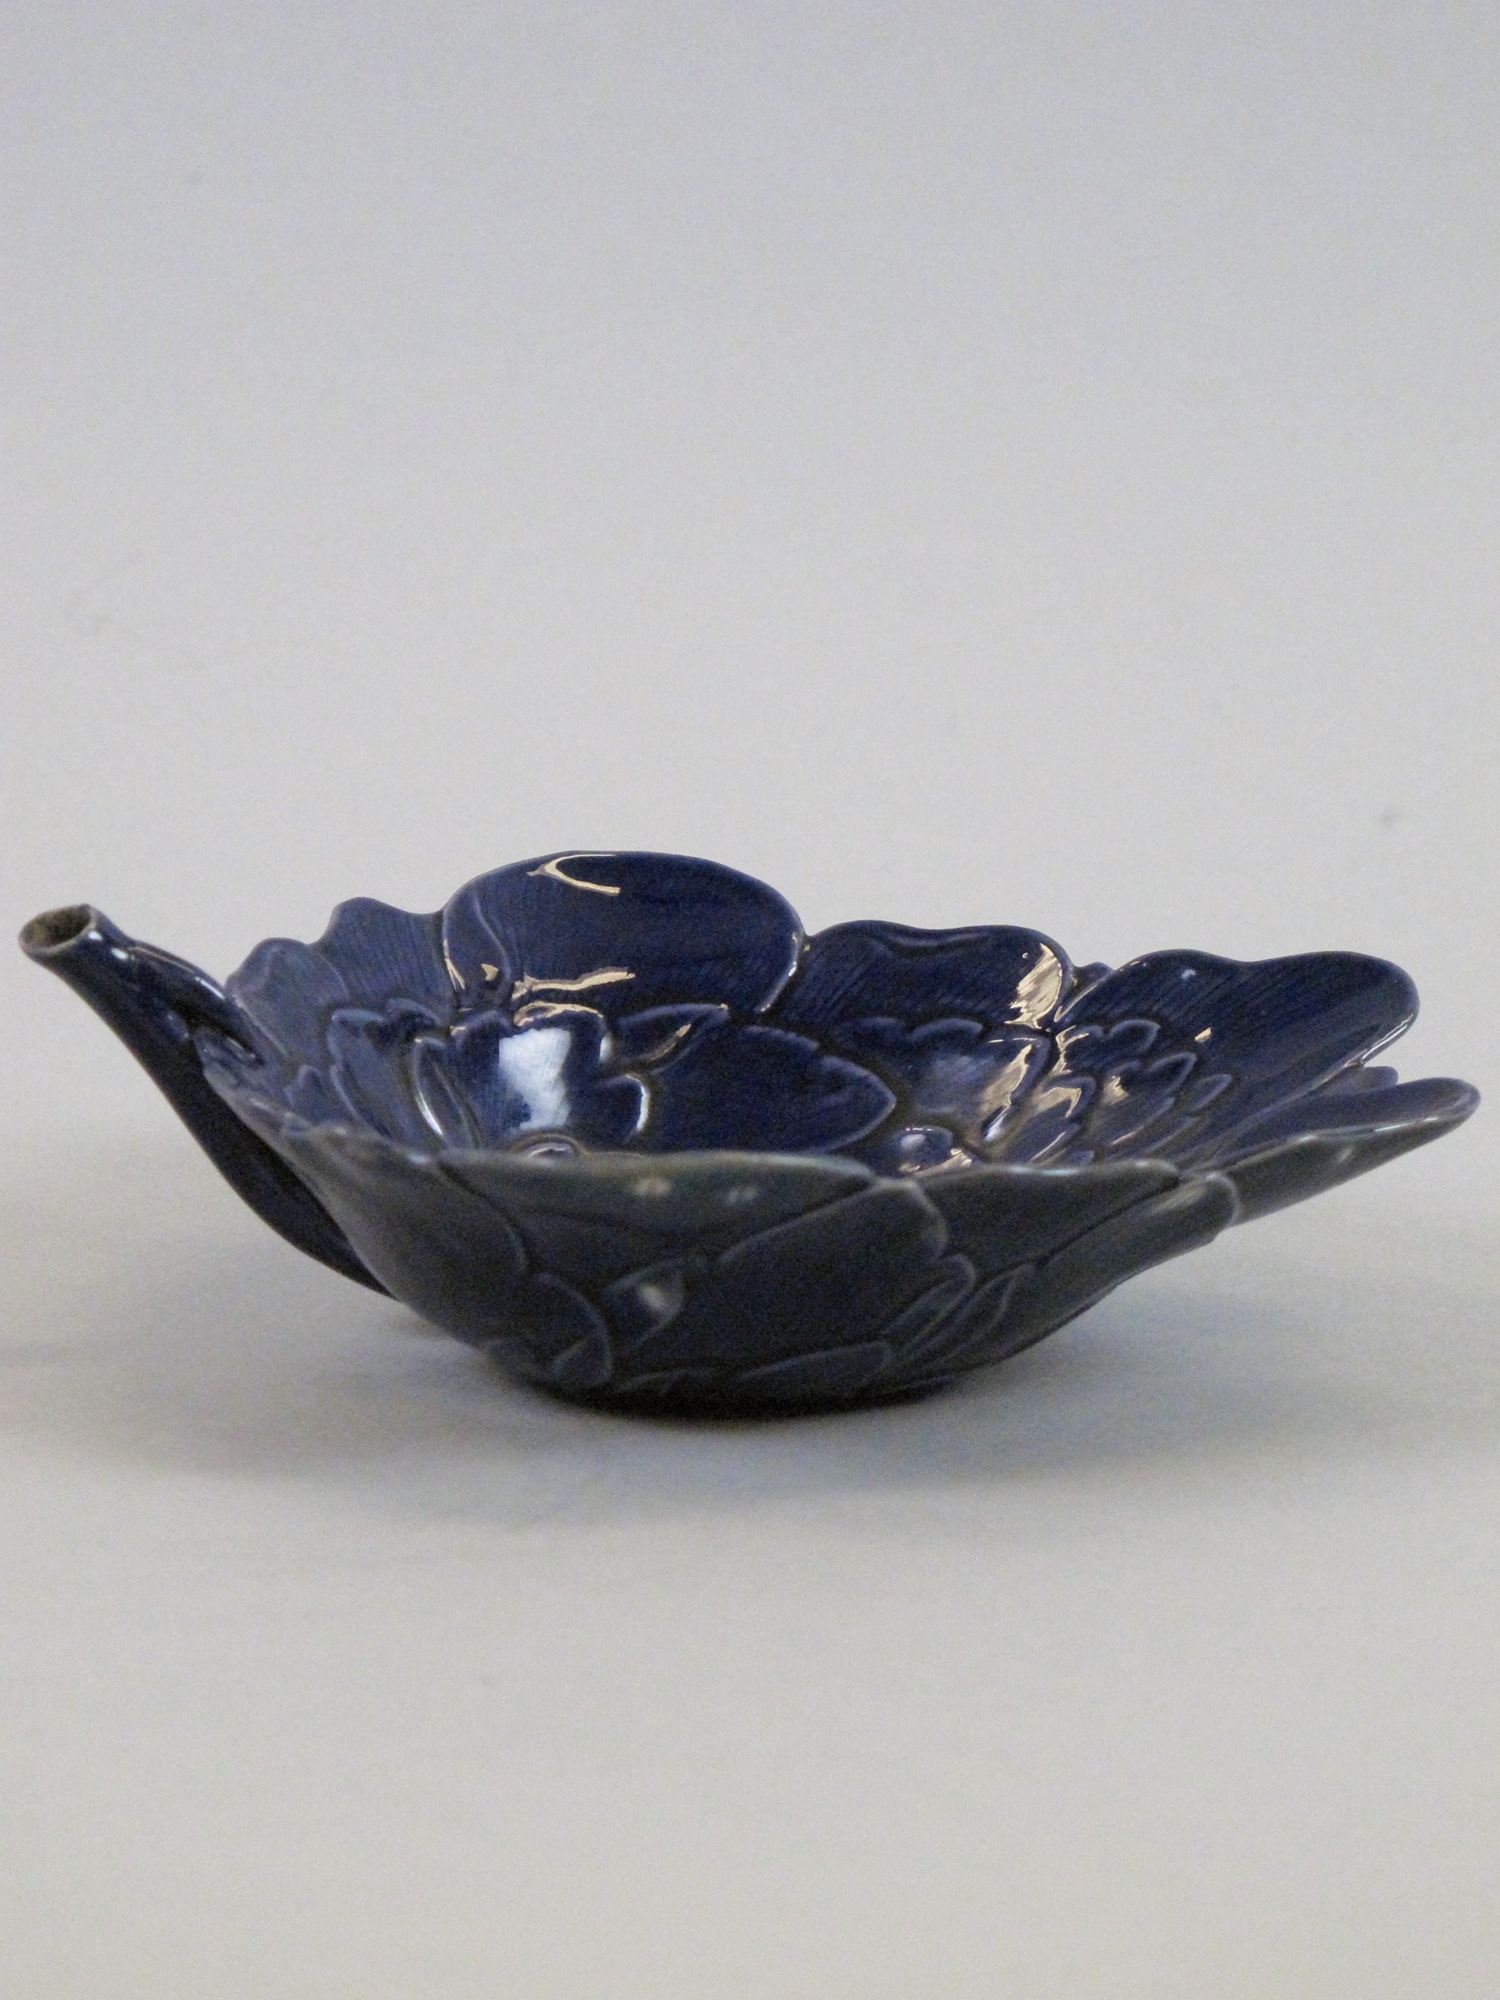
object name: cup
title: Lotus cup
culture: chinese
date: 1801-1900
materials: glaze, porcelain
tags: flowers